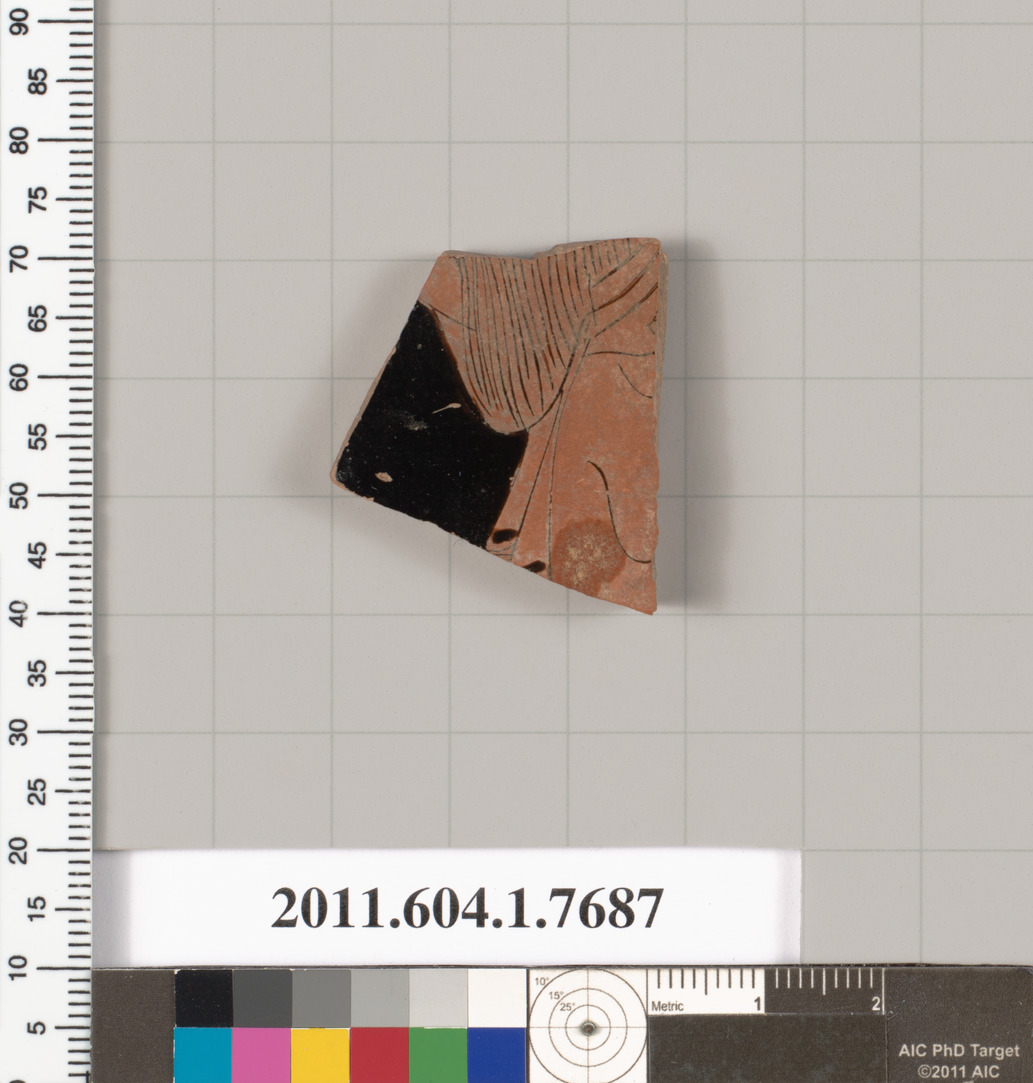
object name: kylix fragment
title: Terracotta fragment of a kylix (drinking cup)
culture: greek, attic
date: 470-460 BCE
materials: terracotta